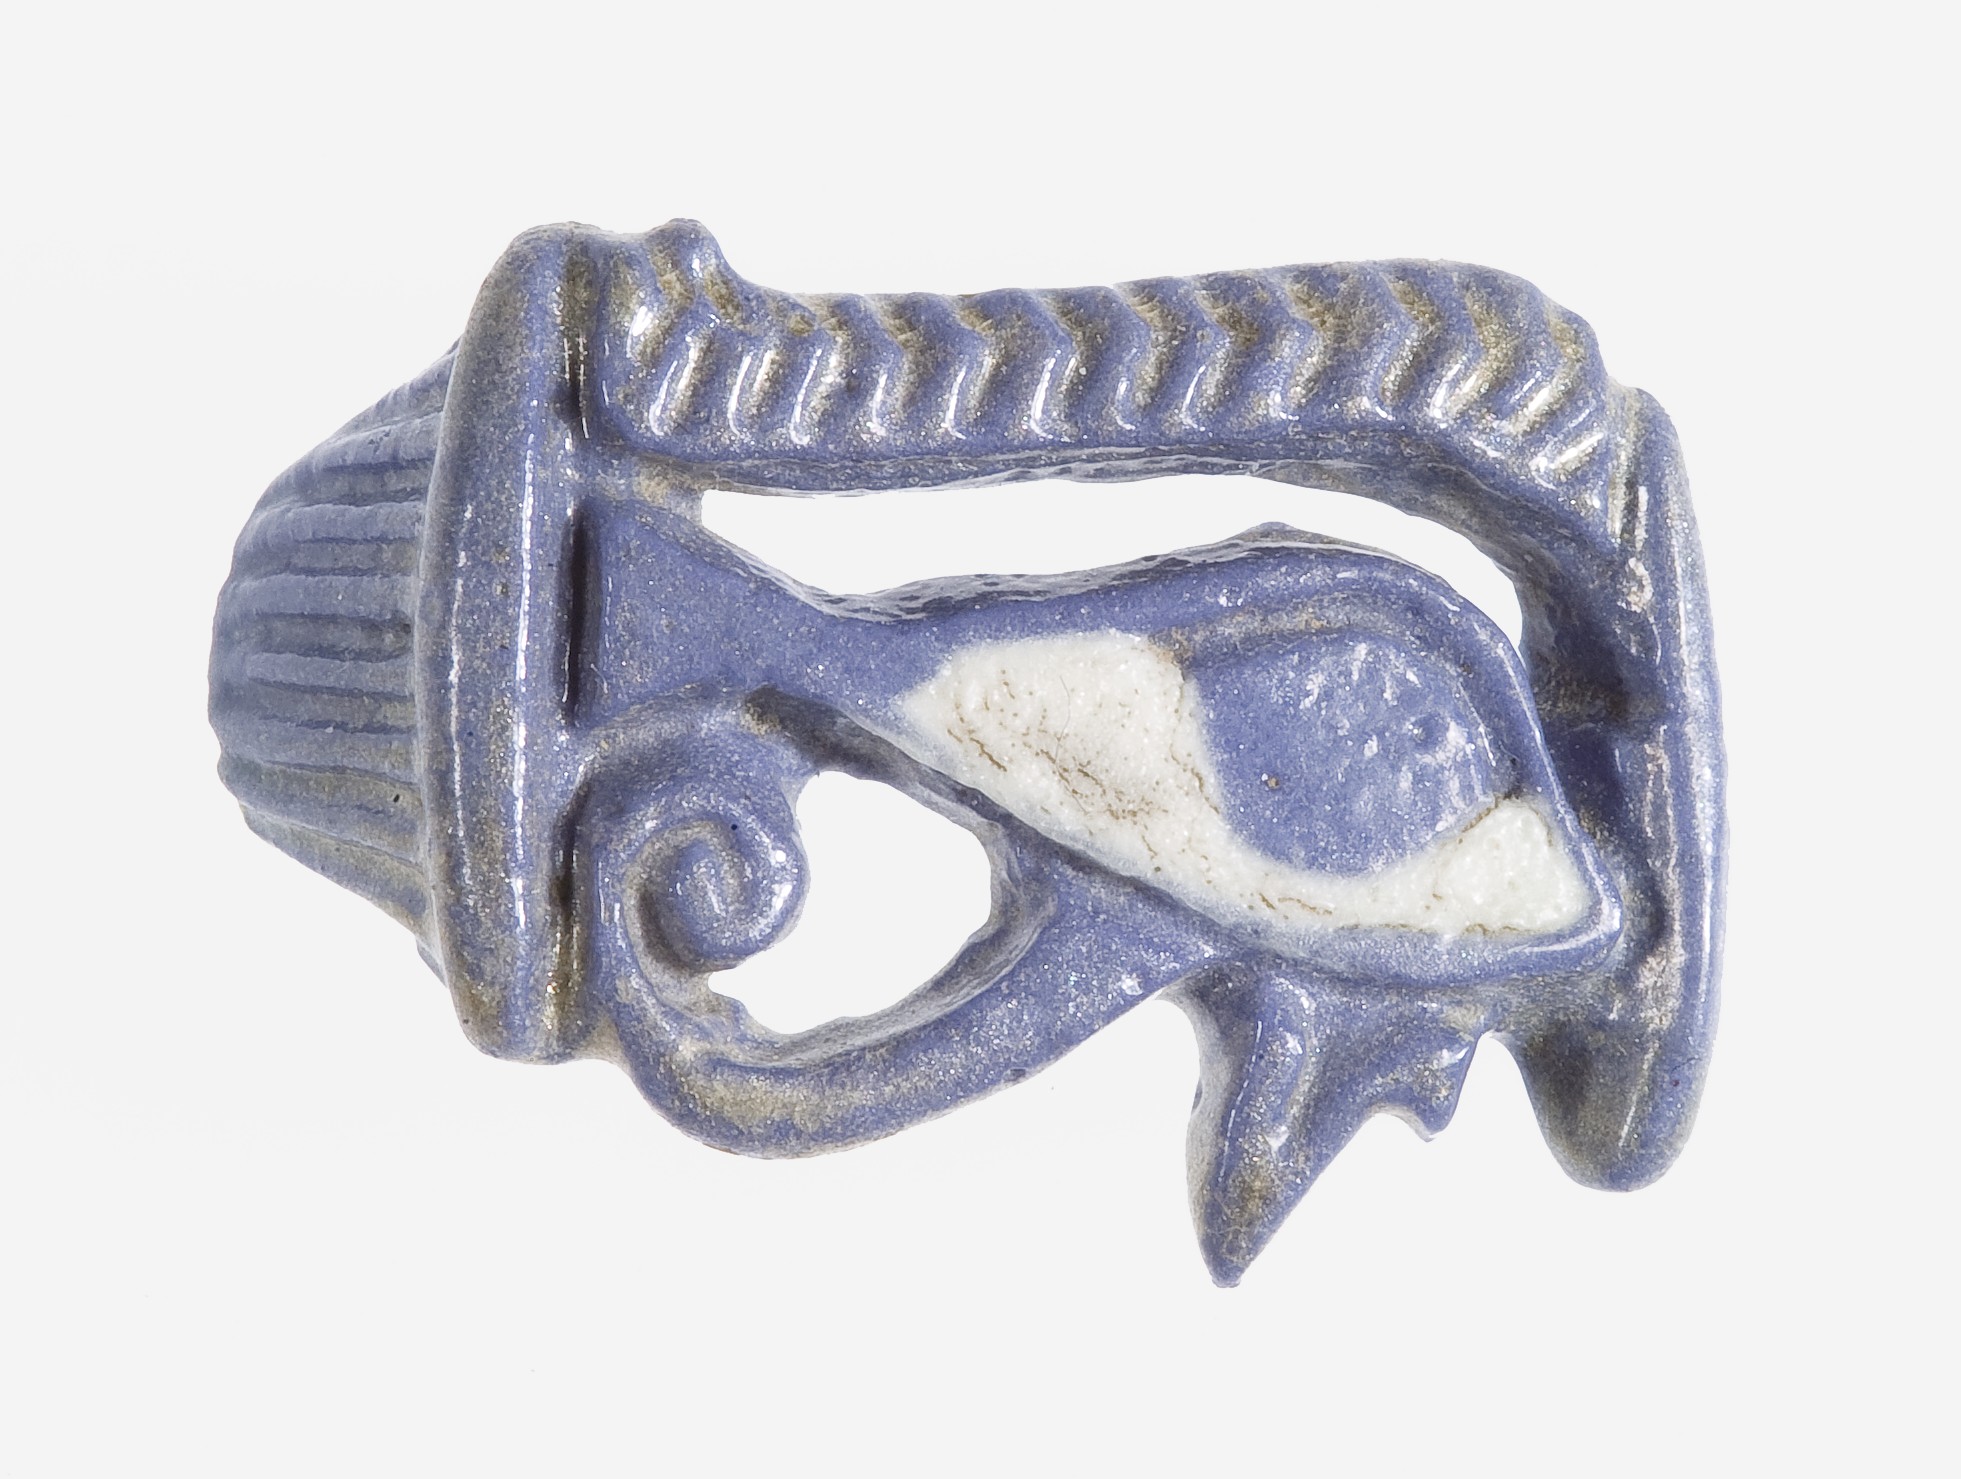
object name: ring, wedjat eye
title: Fragment of a Wedjat Eye Ring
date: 1390-1352 BCE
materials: faience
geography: egypt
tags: eyes